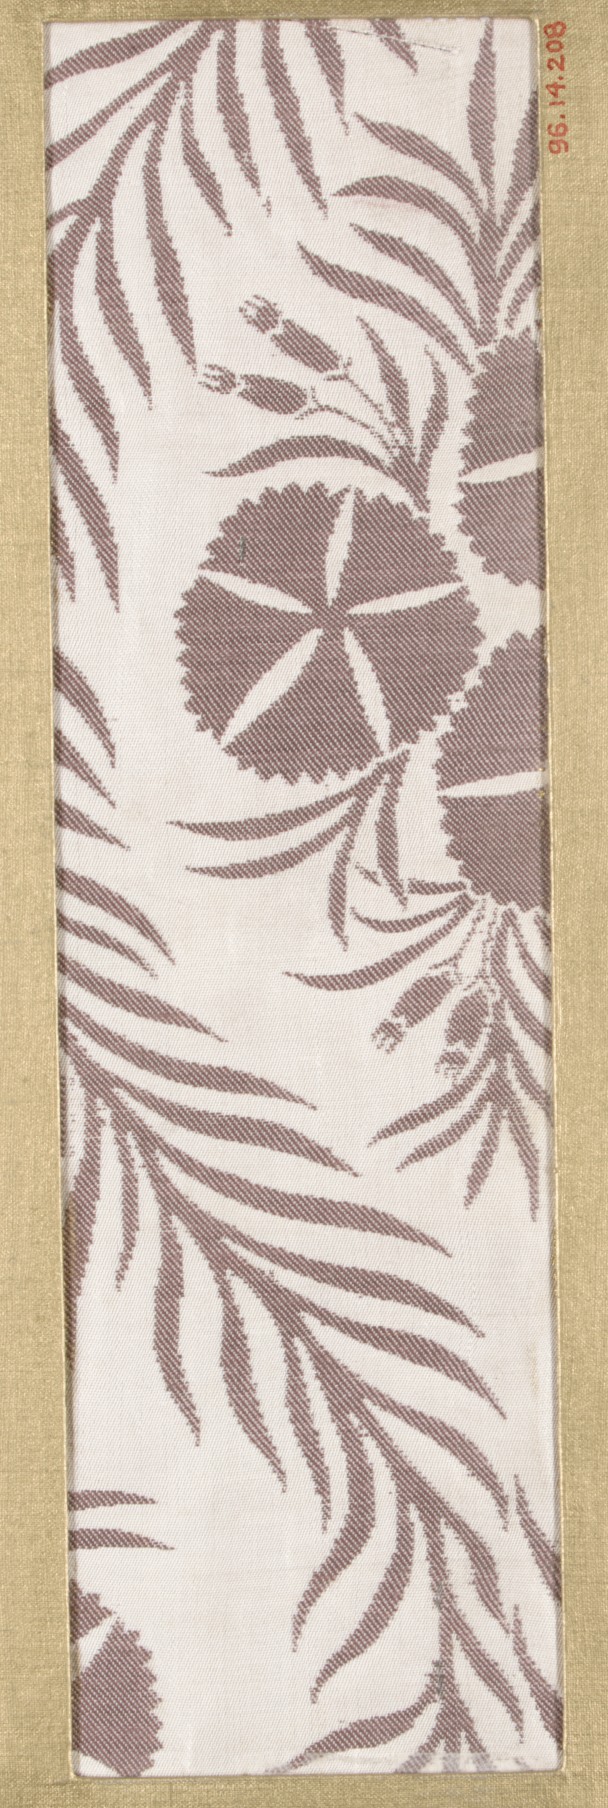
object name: piece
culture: japanese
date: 1701-1900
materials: silk